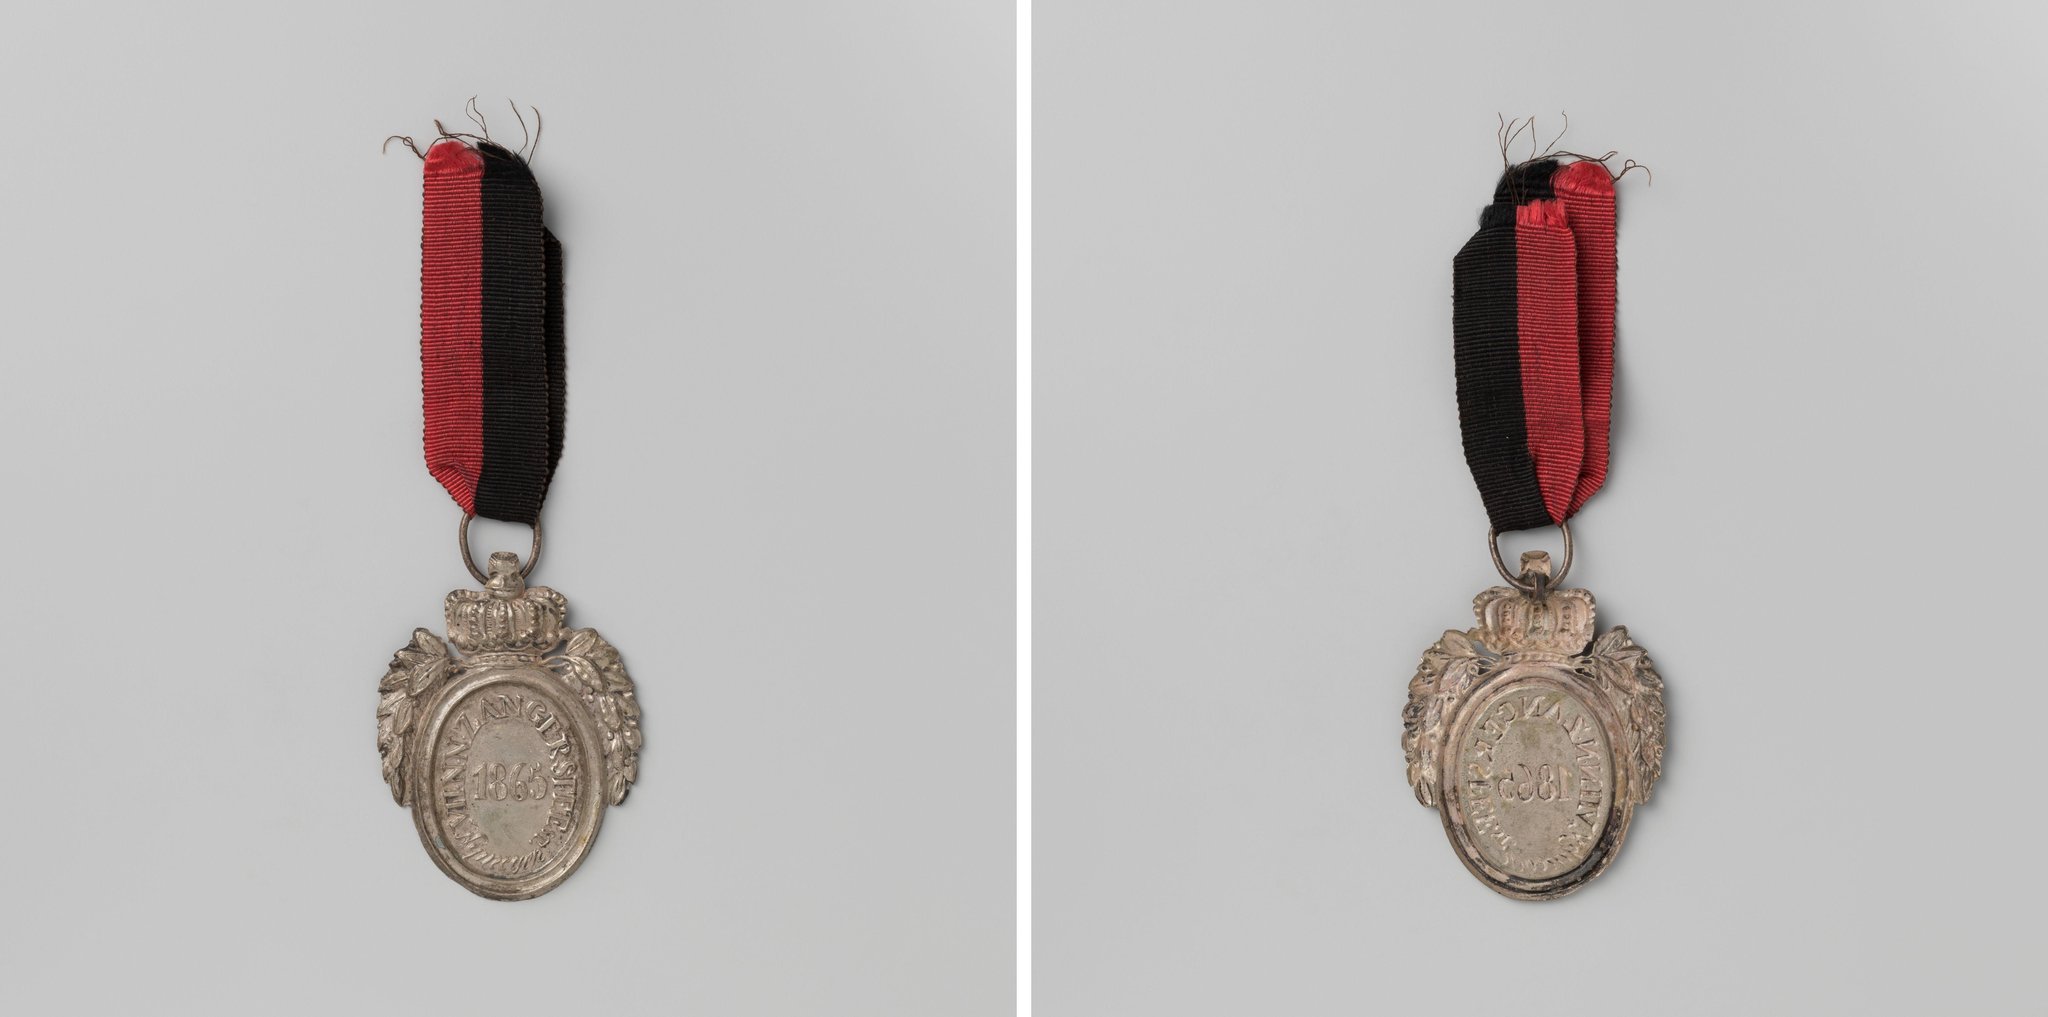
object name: insignia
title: Zevende Nederlandsch nationaal zangersfeest te Nijmegen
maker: Anonymous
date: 1865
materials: copper, textile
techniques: silvering, striking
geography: nijmegen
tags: nijmegen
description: eenzijdig insigne, opgebouwd uit ovaal medaillon onder kroon, waarvan lauwertakken afhangen aan draagoog, draagring en lint met verticale, zwarte en rode baan; op medaillon: jaartal binnen omschrift